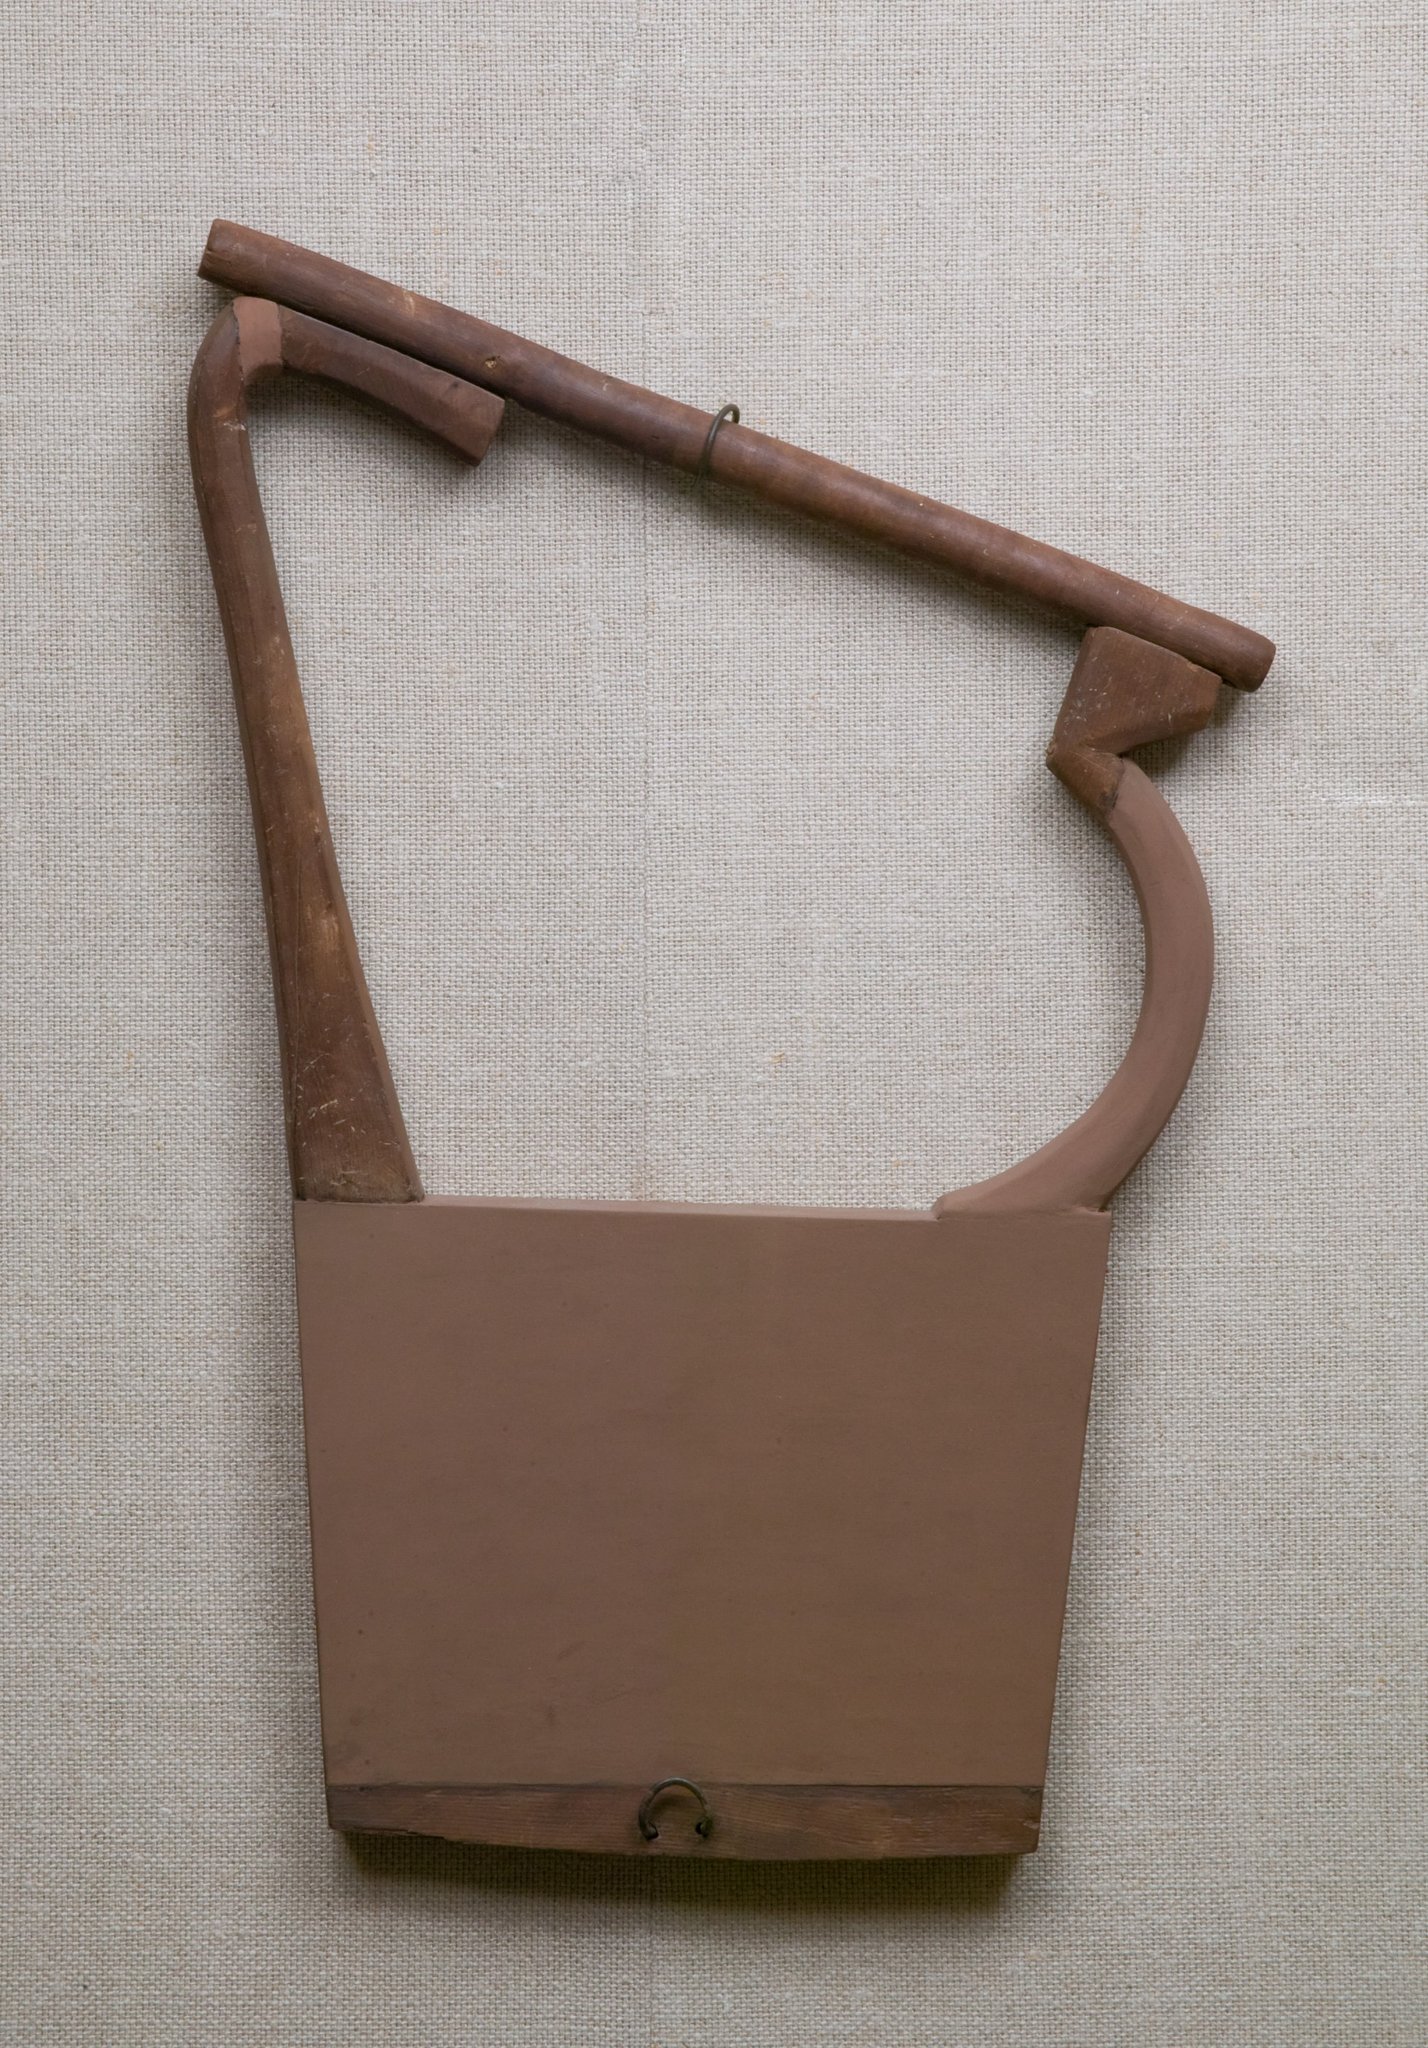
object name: music, lyre, oblique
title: Partially Restored Oblique Lyre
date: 1550-1458 BCE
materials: bronze, copper alloy, wood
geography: egypt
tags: musical instruments